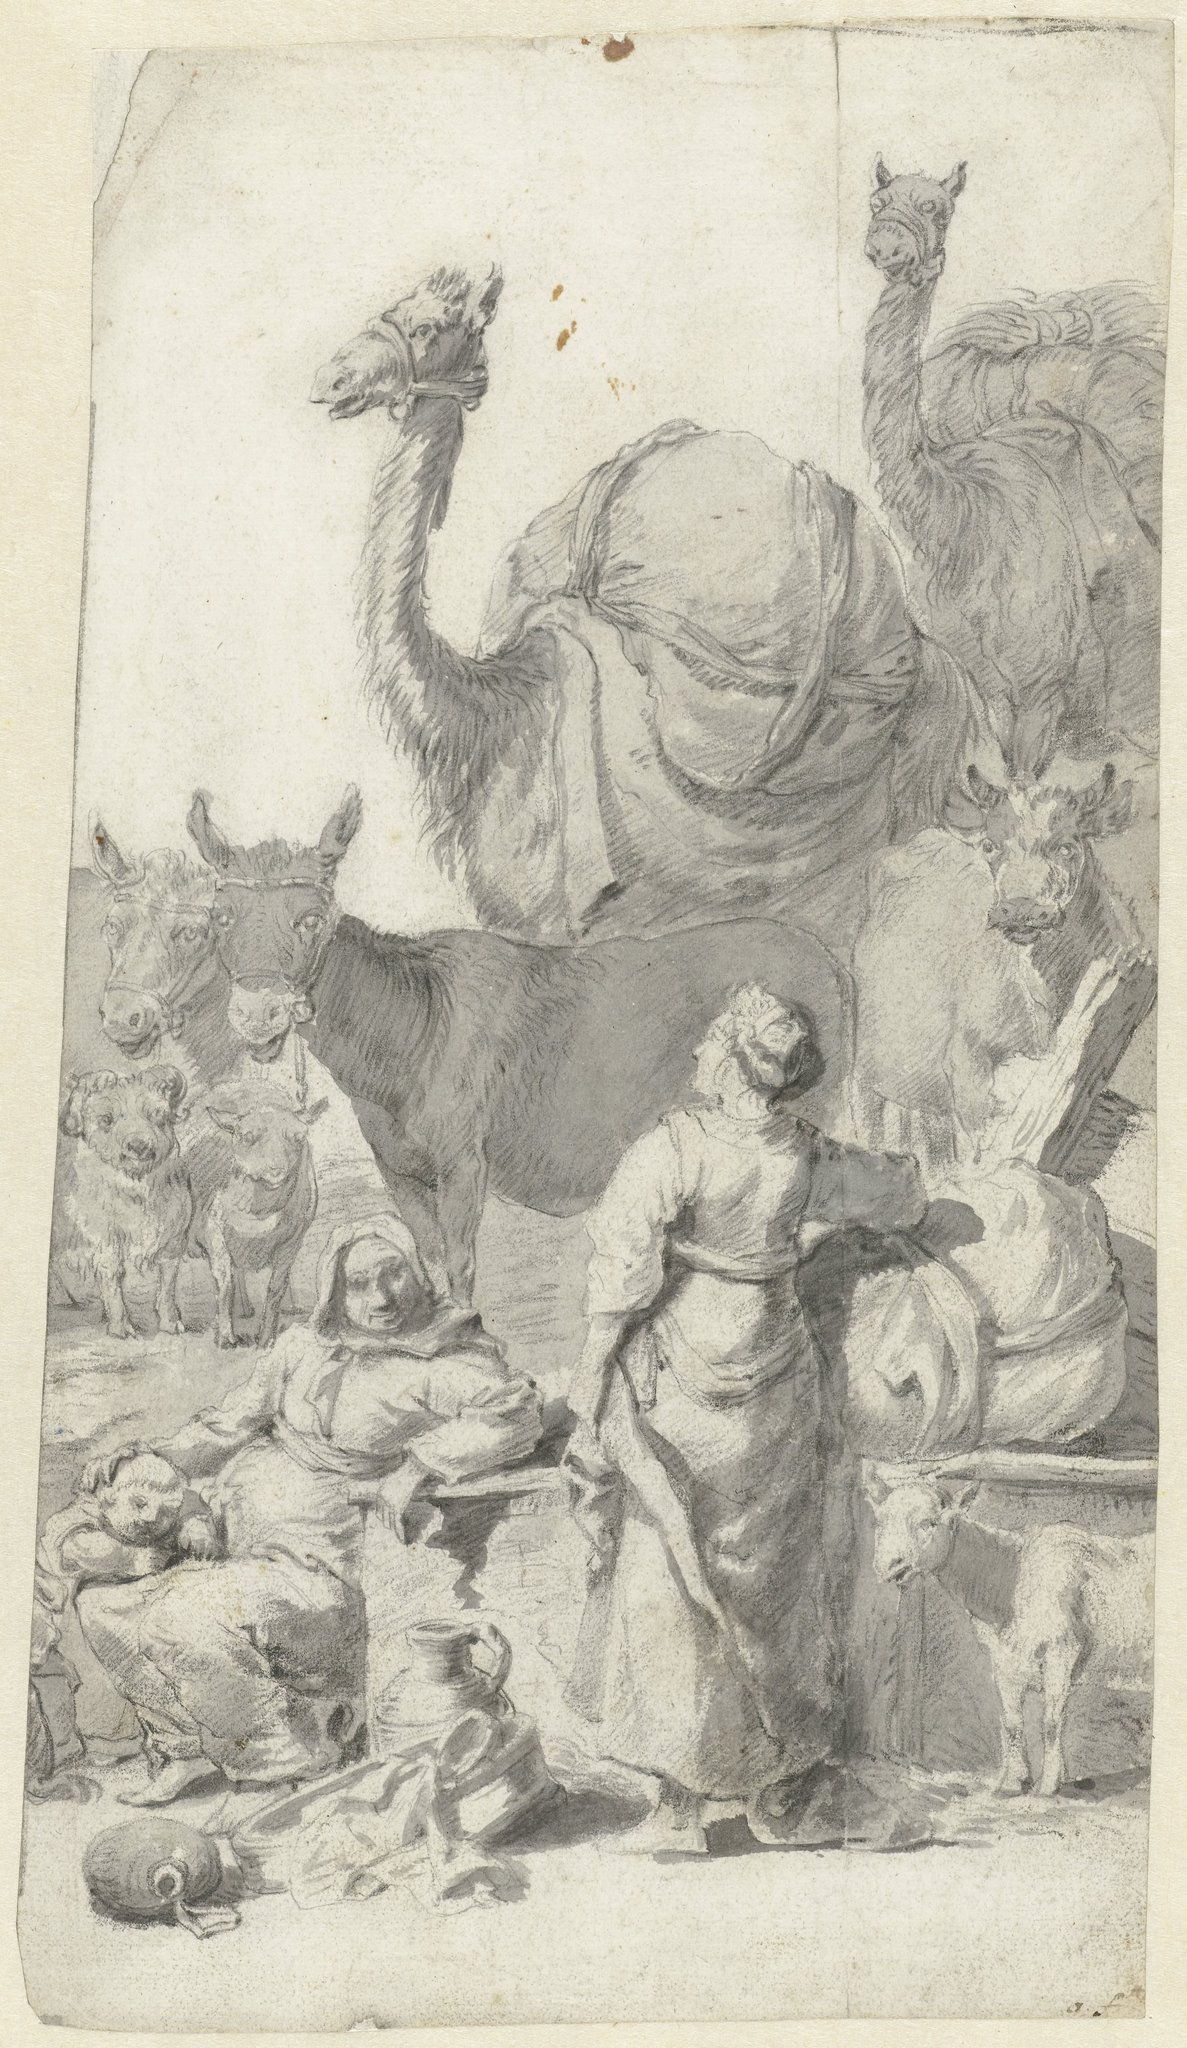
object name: drawing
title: Fragment met de ontmoeting van Jacob en Esau (?)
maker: Anonymous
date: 1600-1699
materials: chalk, paper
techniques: brush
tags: hoofed animals: camel, ass, donkey, sheep, animal mounts; pack-animals, goat, jacob and esau are reconciled (genesis 33)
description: Fragment van een tekening met de ontmoeting van Jacob en Esau (?).